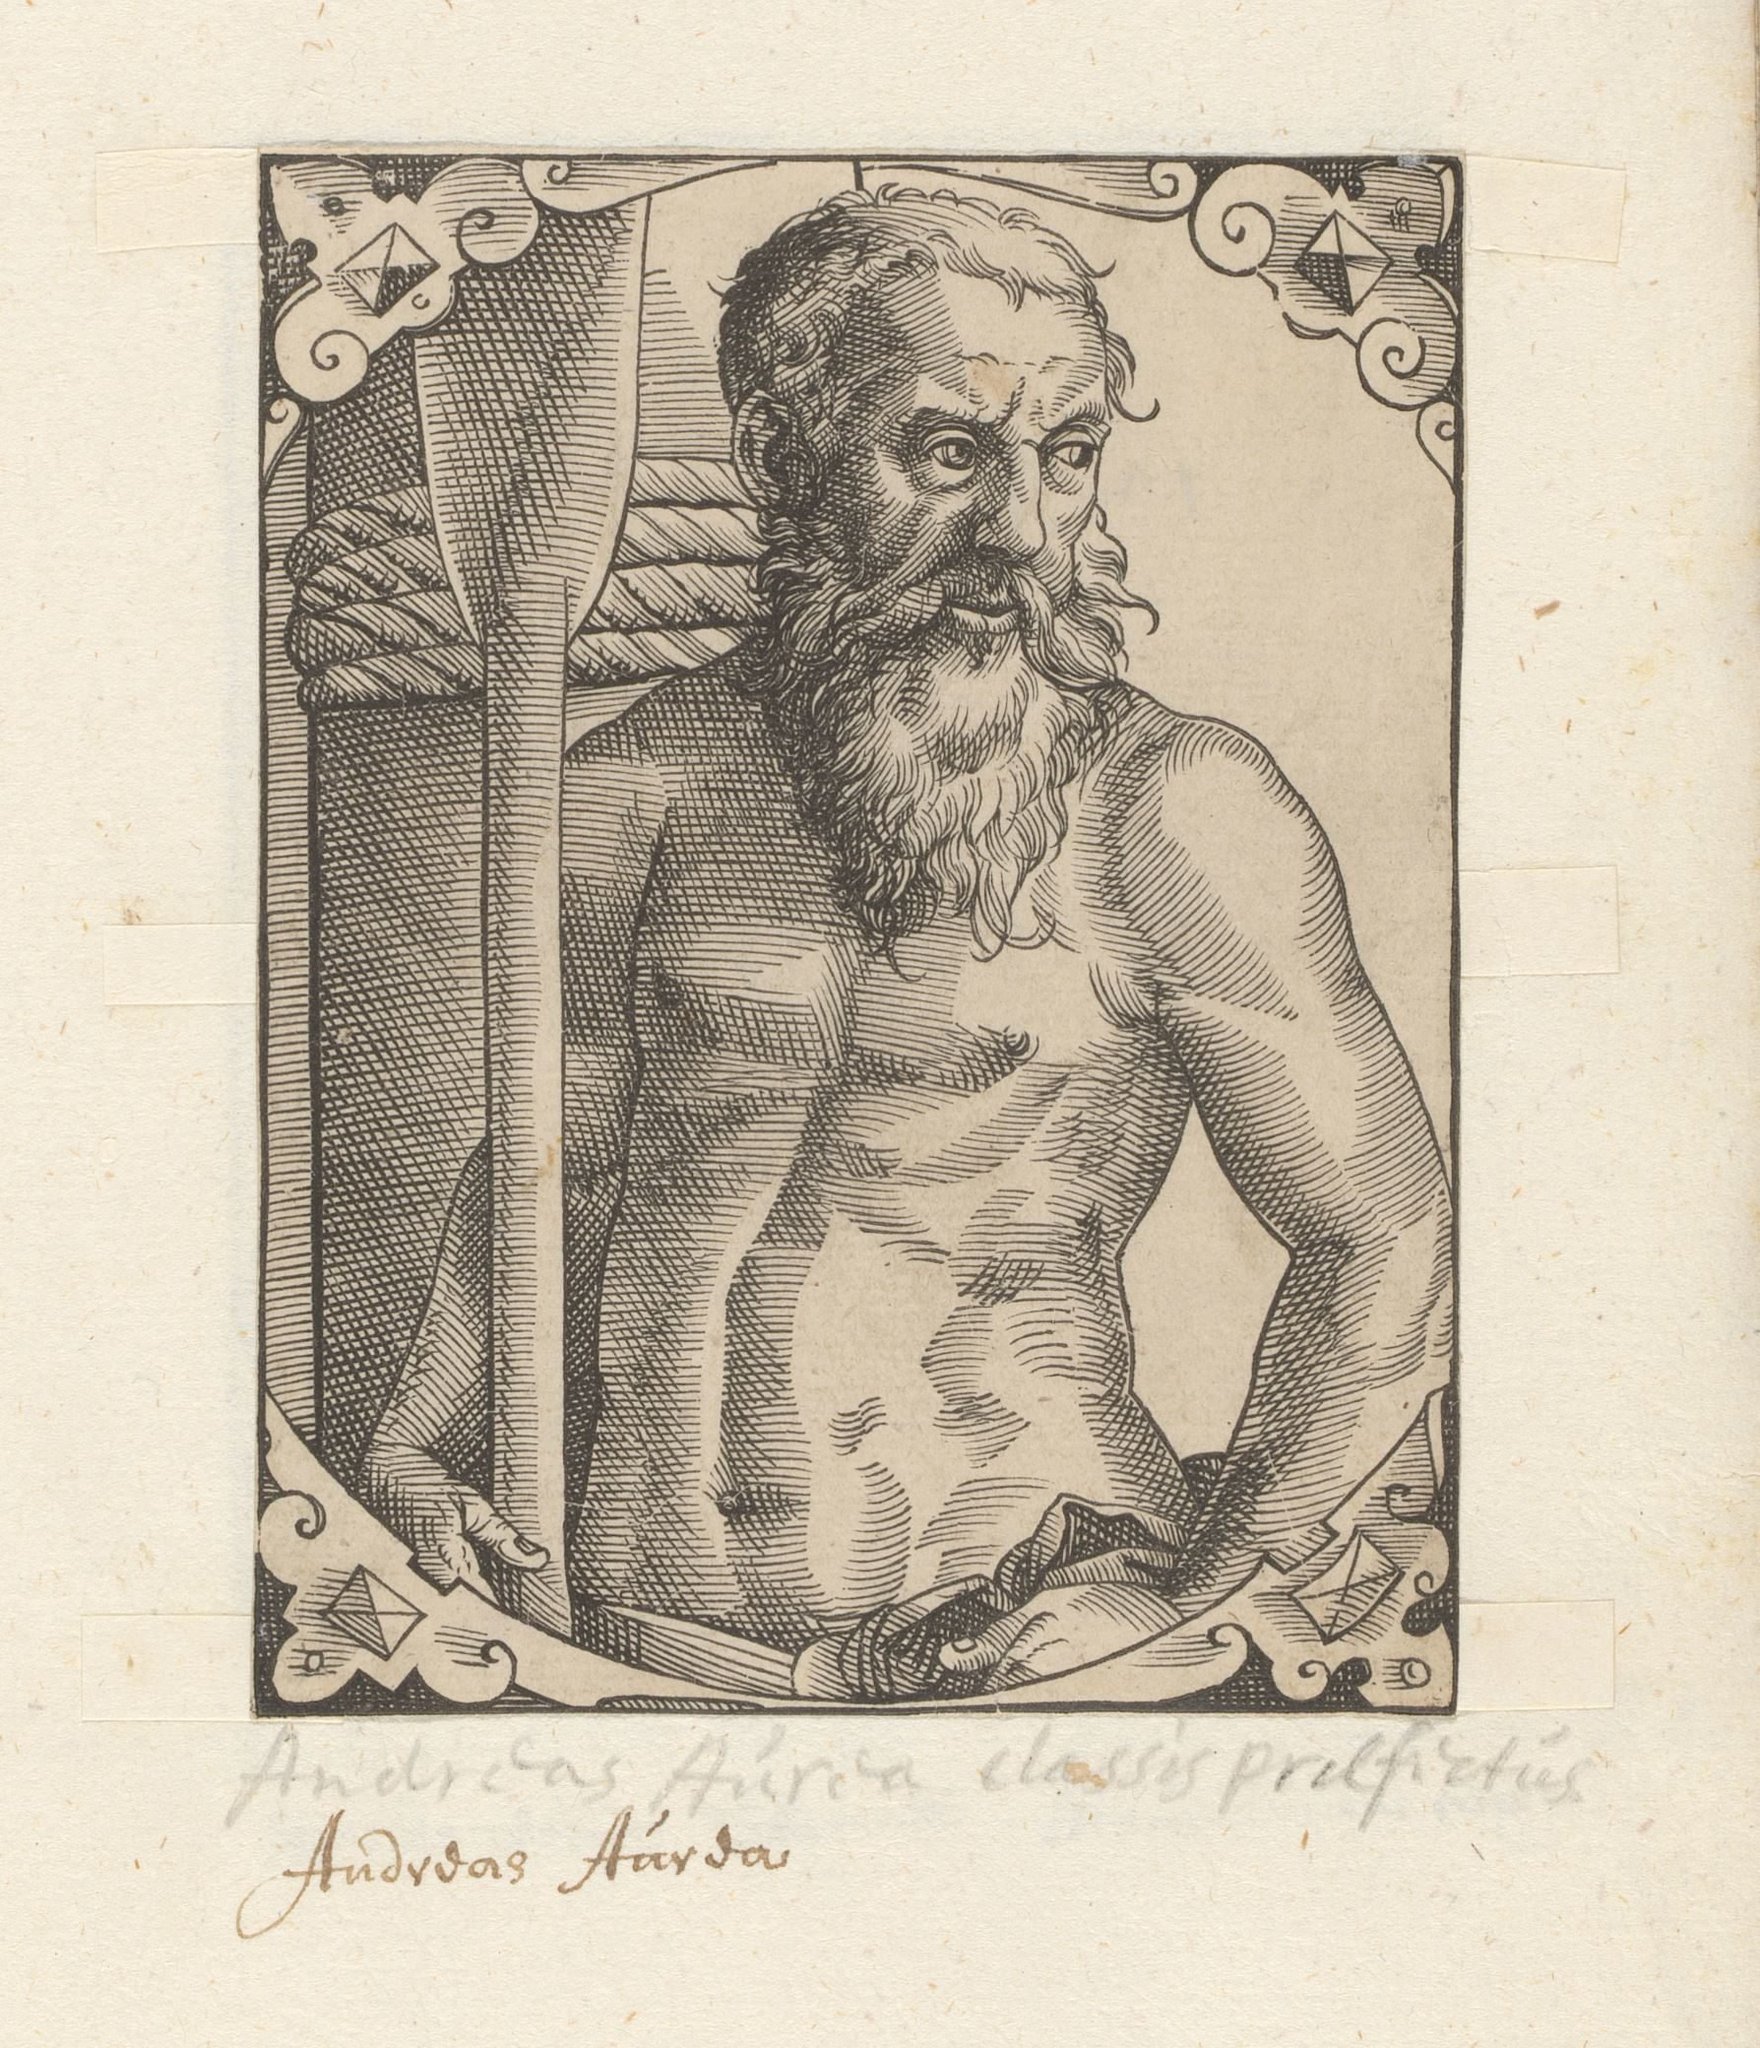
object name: book illustration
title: Portret van Andrea Doria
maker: Anonymous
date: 1549-1575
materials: paper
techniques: woodcut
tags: historical persons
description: Prent gebruikt in: Giovio, Paolo. Elogia Virorum bellica virtute illustrium (...). Bazel: Peter Perna, 1575.